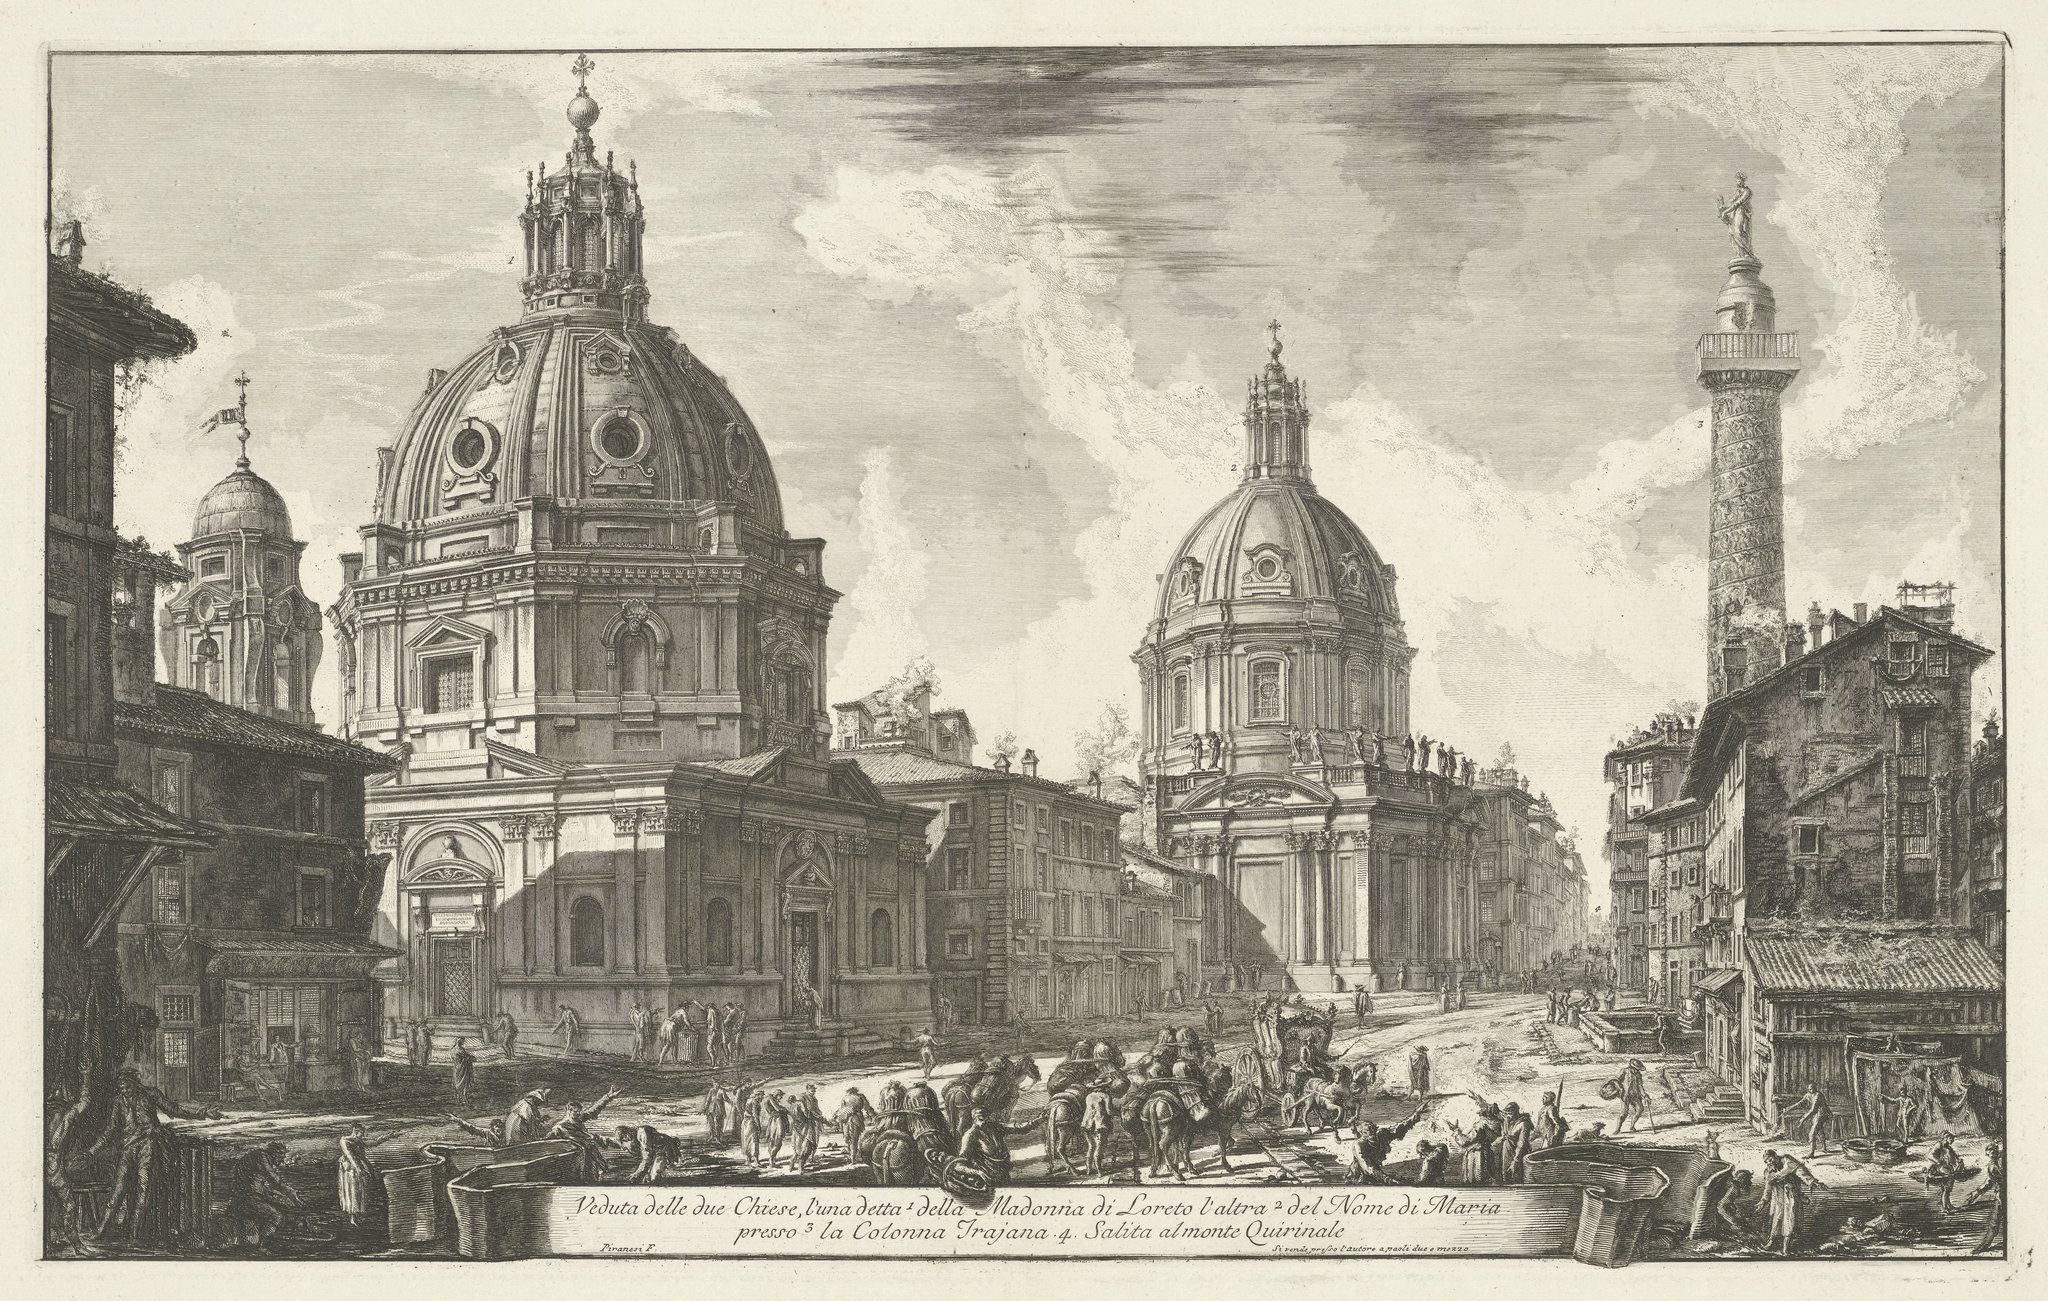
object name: print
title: Vedute di Roma disegnate ed incise da Giambattista Piranesi architetto Ve(nez)iano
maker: giovanni battista piranesi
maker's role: designer, draughtsman, print maker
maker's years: 1720-1778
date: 1748-1778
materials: paper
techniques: etching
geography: rome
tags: city-view, and landscape with man-made constructions, church (exterior), triumphal column with helical friezes, roman catholic church, parts of church exterior and annexes: façade, street, rome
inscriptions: collector's mark: Lugt 2228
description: Deze prent maakt deel uit van de serie 'Vedute di Roma'. Piranesi werkte aan deze 135 platen tellende serie tussen 1748 en zijn dood in 1778. Francesco Piranesi voegde later nog twee prenten toe aan de reeks van zijn vader.